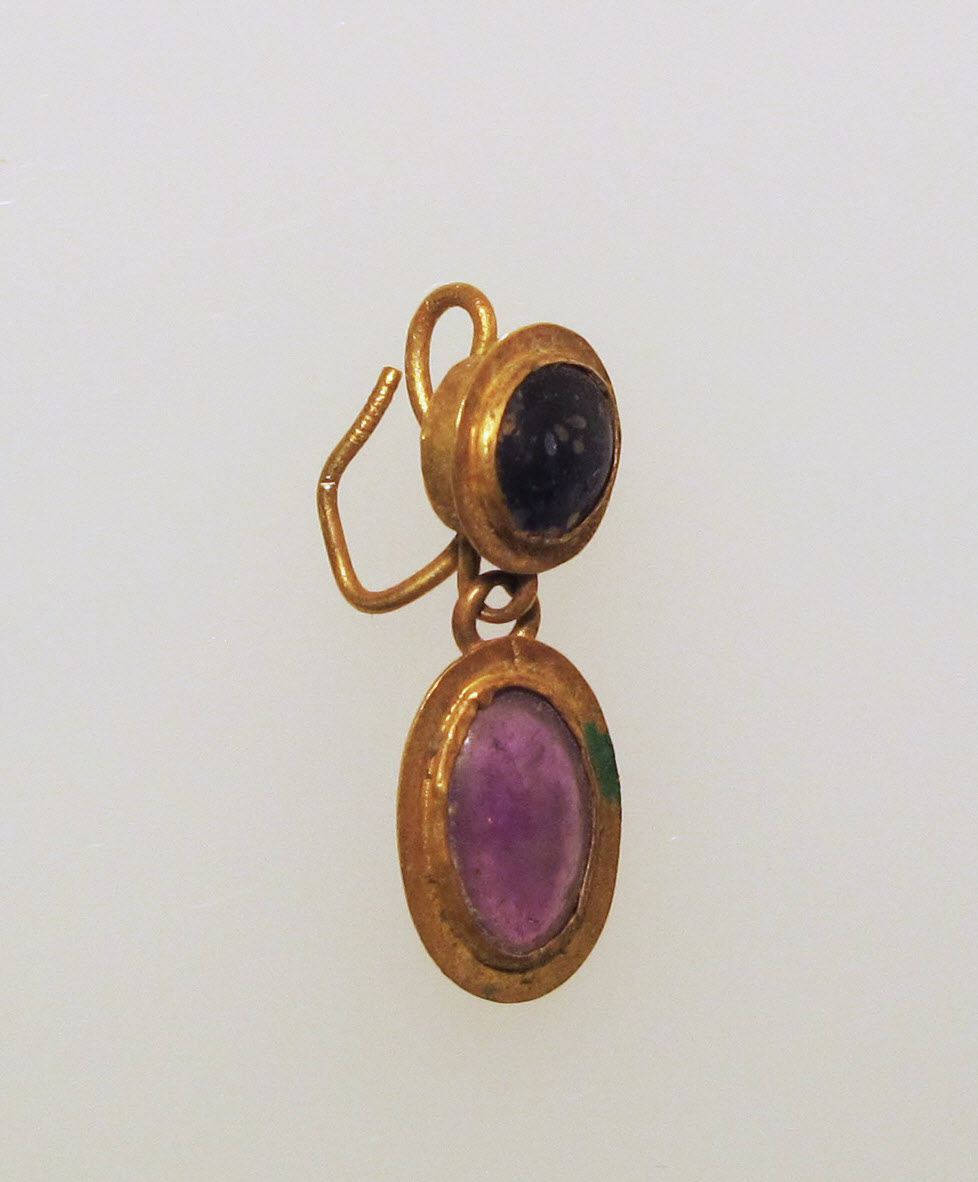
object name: earring, hook type with amethyst setting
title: Earring-hook type with amethyst and paste settings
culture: roman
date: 101-200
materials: gemstone, glass, gold, paste